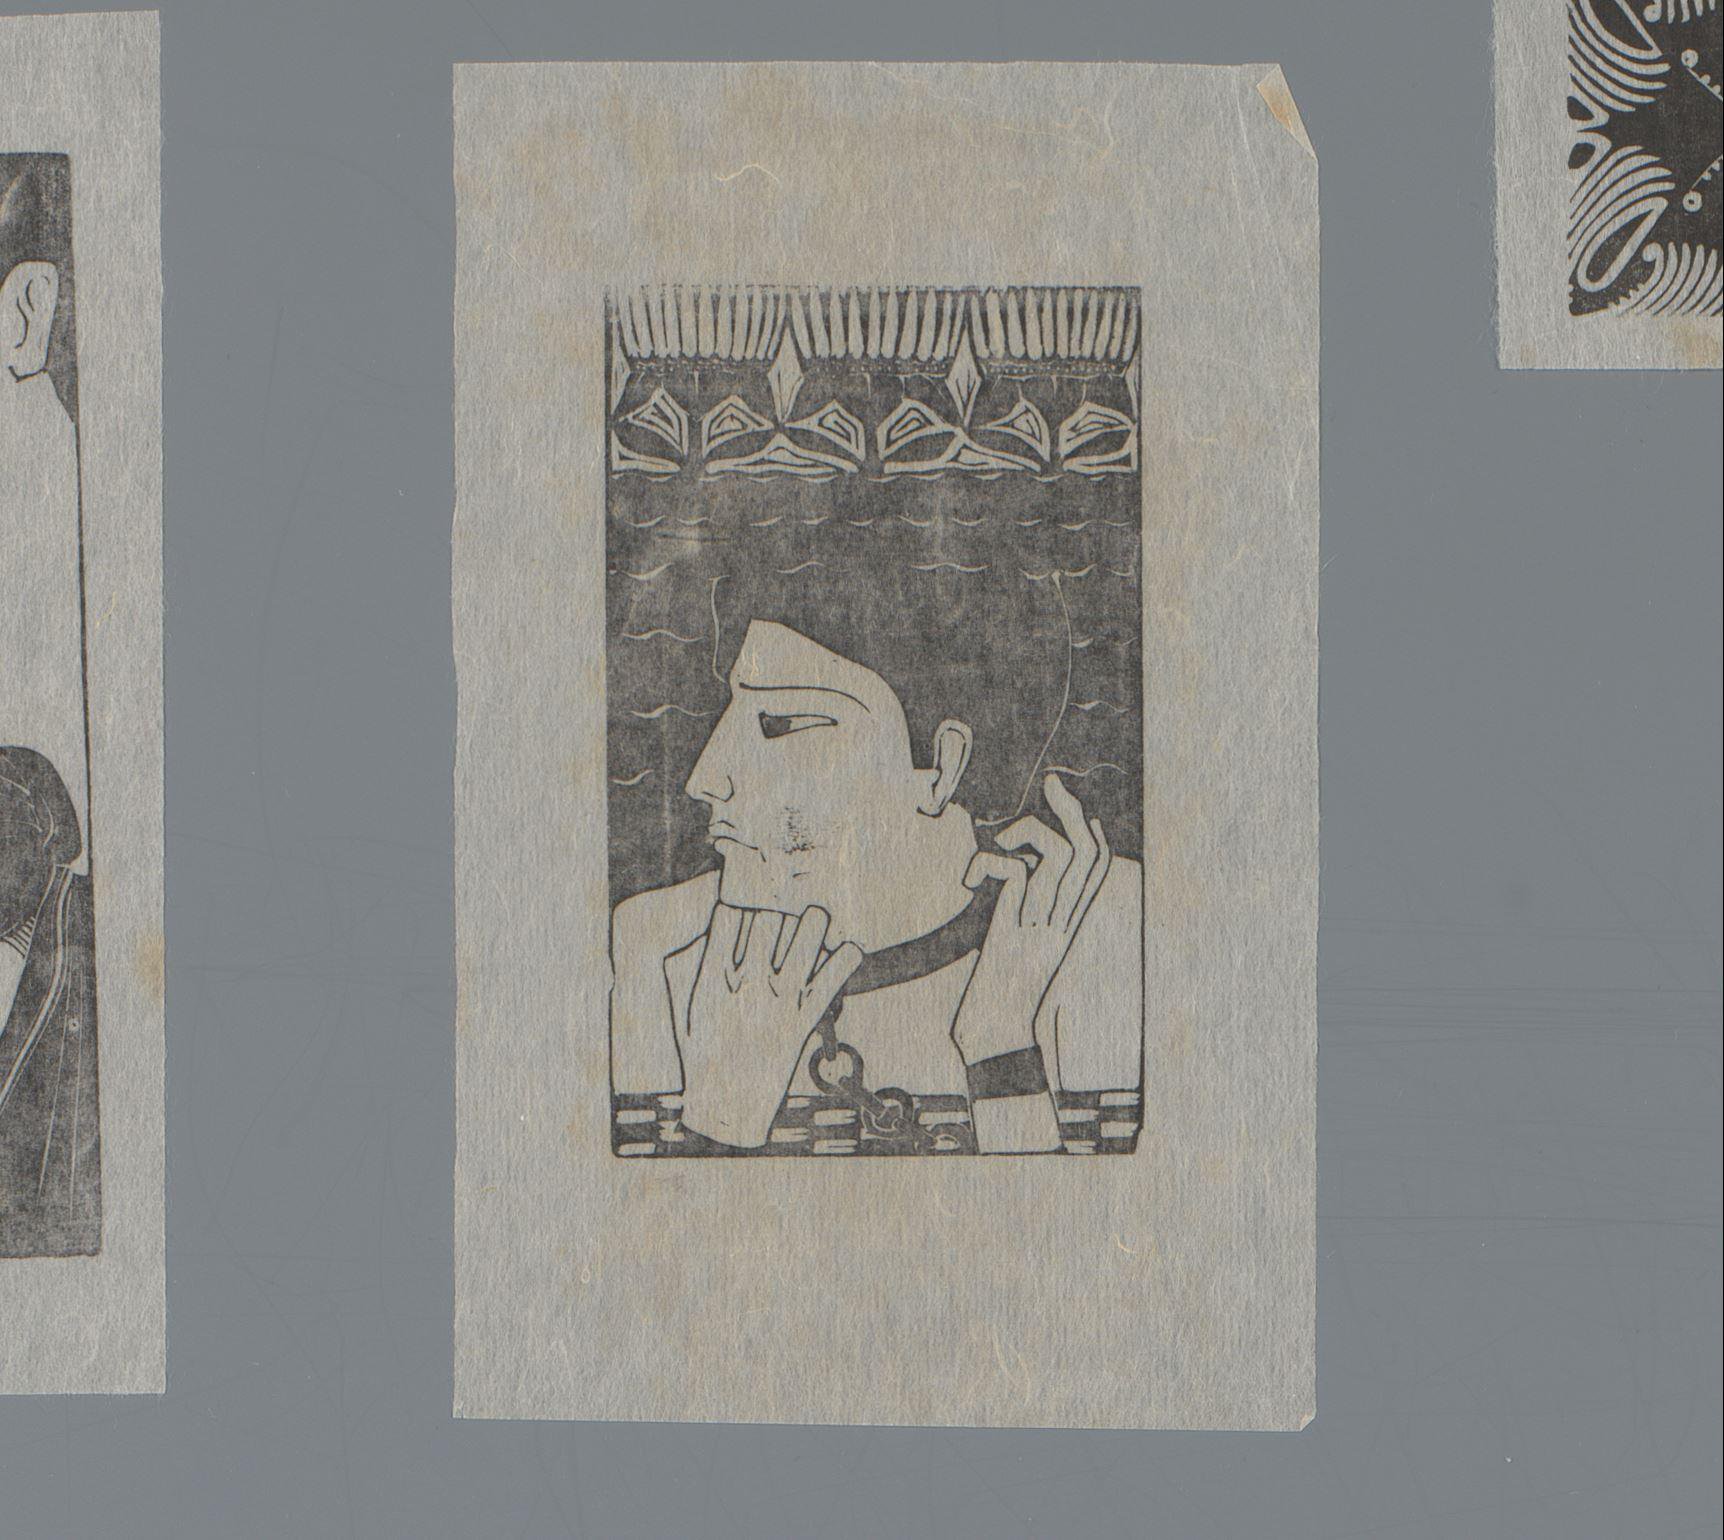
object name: print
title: Onderste gedeelte van de prent 'Lente gedachten'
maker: karel petrus cornelis de bazel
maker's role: draughtsman, print maker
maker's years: 1869-1923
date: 1895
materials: paper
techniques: woodcut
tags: prisoner; in fetters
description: Losse afdruk van het onderste blok voor de prent uit: Licht en waarheid, orgaan van de vereeniging 'Wie denkt overwint', nr. 130, 20 april 1895.